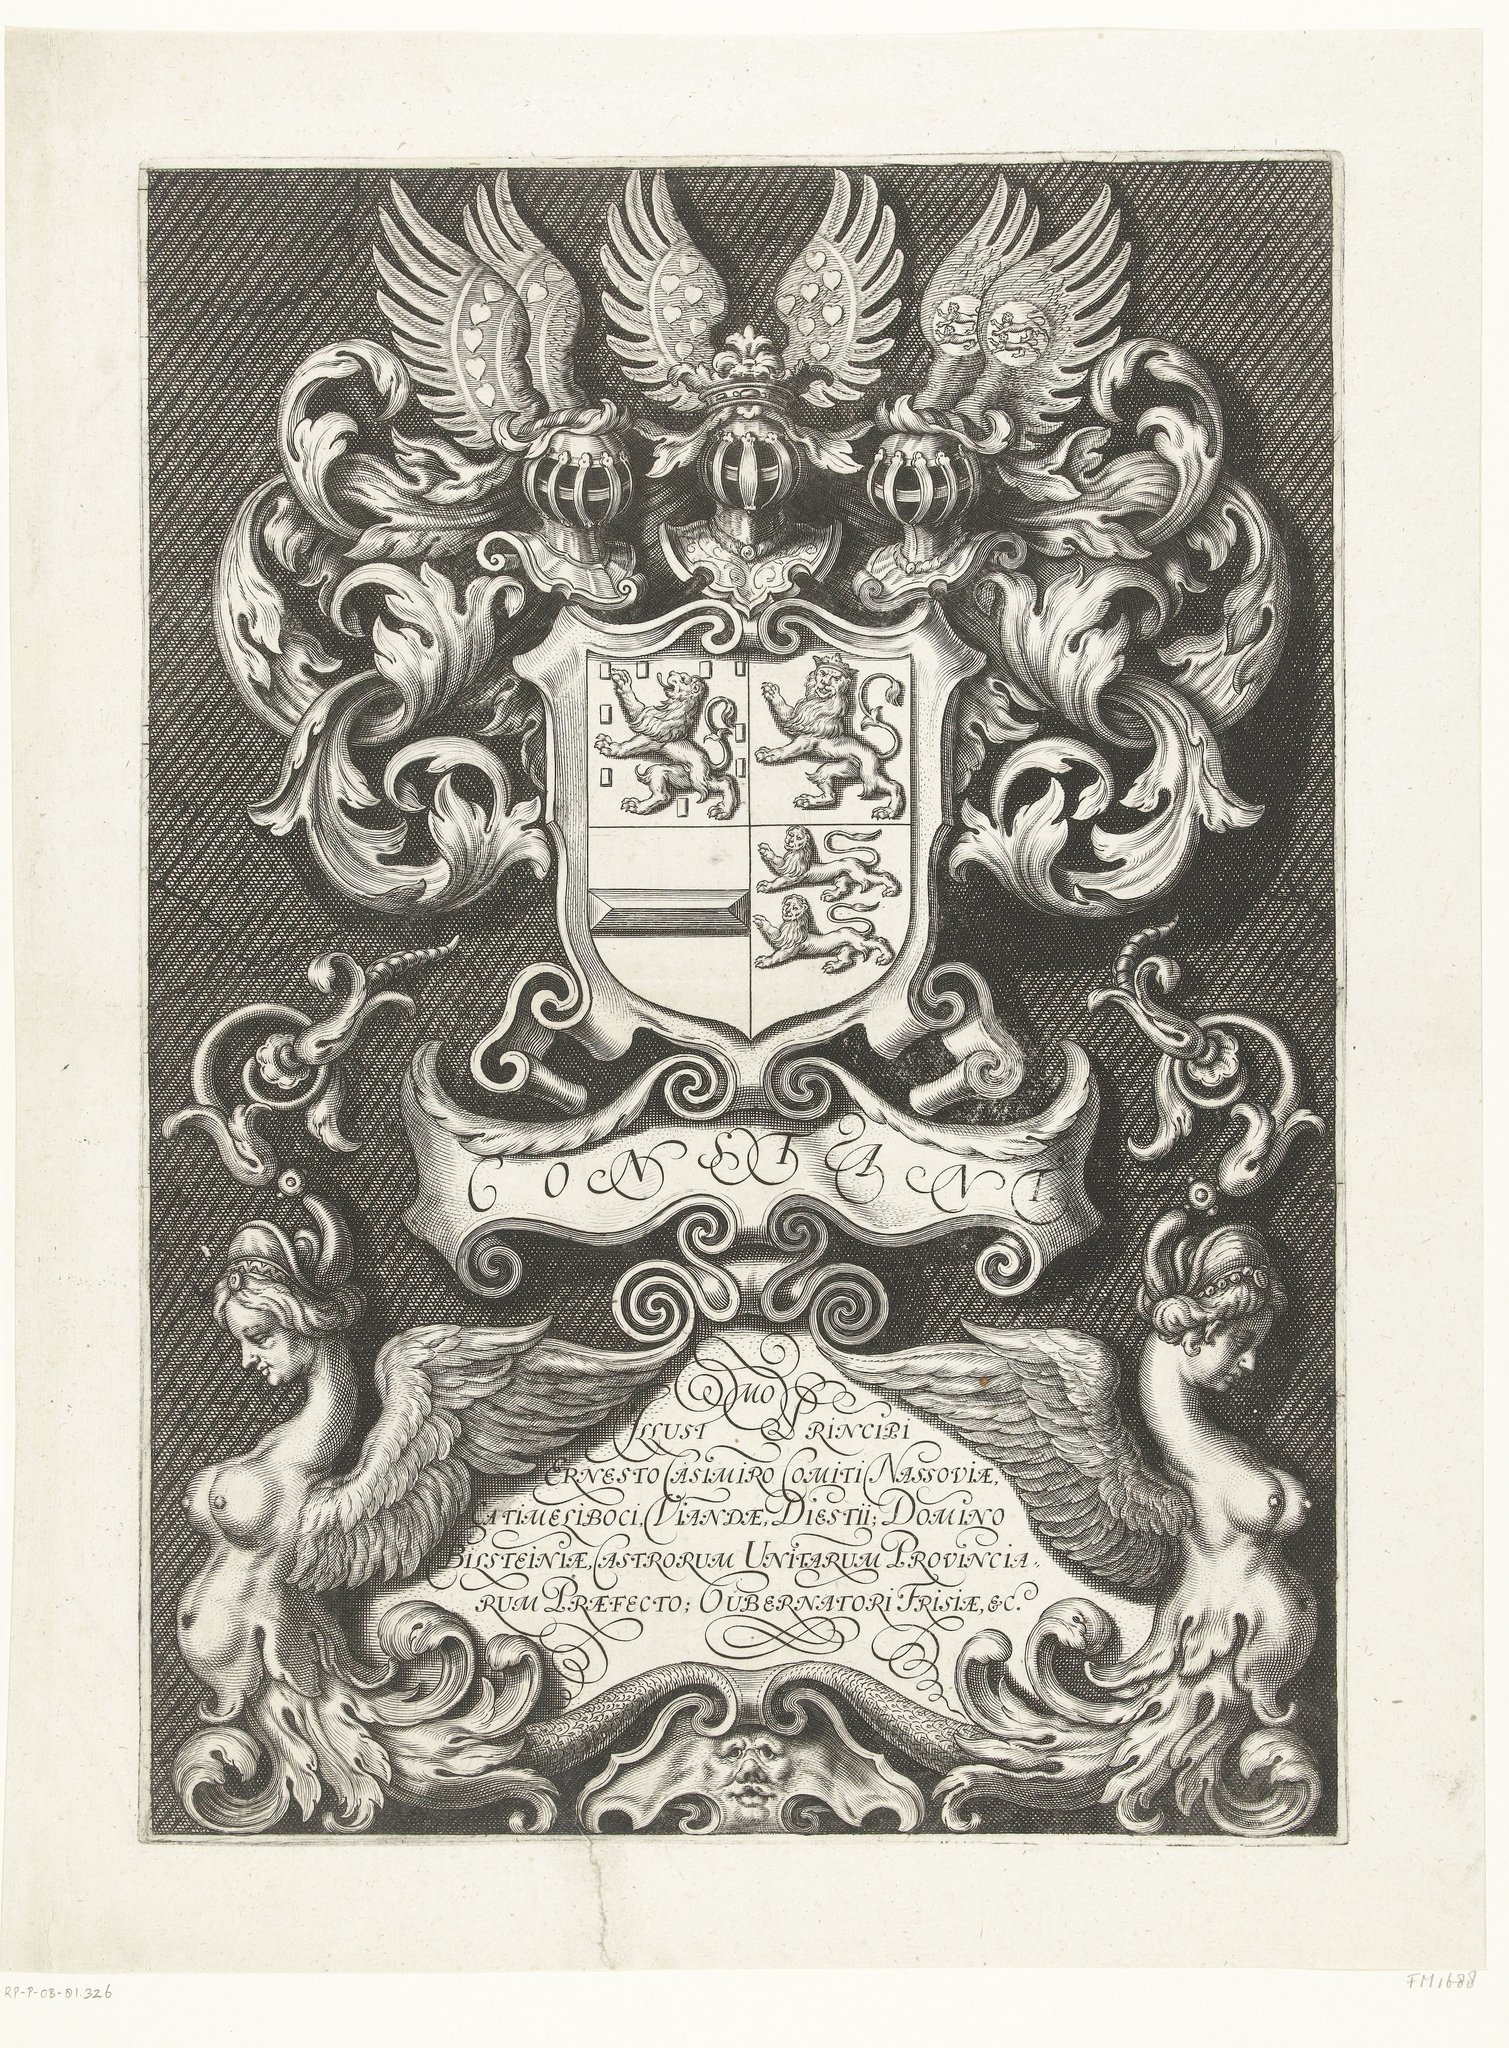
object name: print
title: Wapen van Ernst Casimir, graaf van Nassau-Dietz, 1632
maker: simon van de passe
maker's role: print maker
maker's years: 1595-1647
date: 1626-1628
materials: paper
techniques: engraving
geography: northern netherlands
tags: ernst casimir graaf van nassau-dietz, armorial bearing, heraldry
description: Gebruikt als illustratie in: Gérard Thibault, Academie de l'espée, 1628. Toeschrijving aan Simon van de Passe op basis van zijn signatuur op één van de vergelijkbare platen met wapens in het begin van het boek. Zie ook FMH 1291.